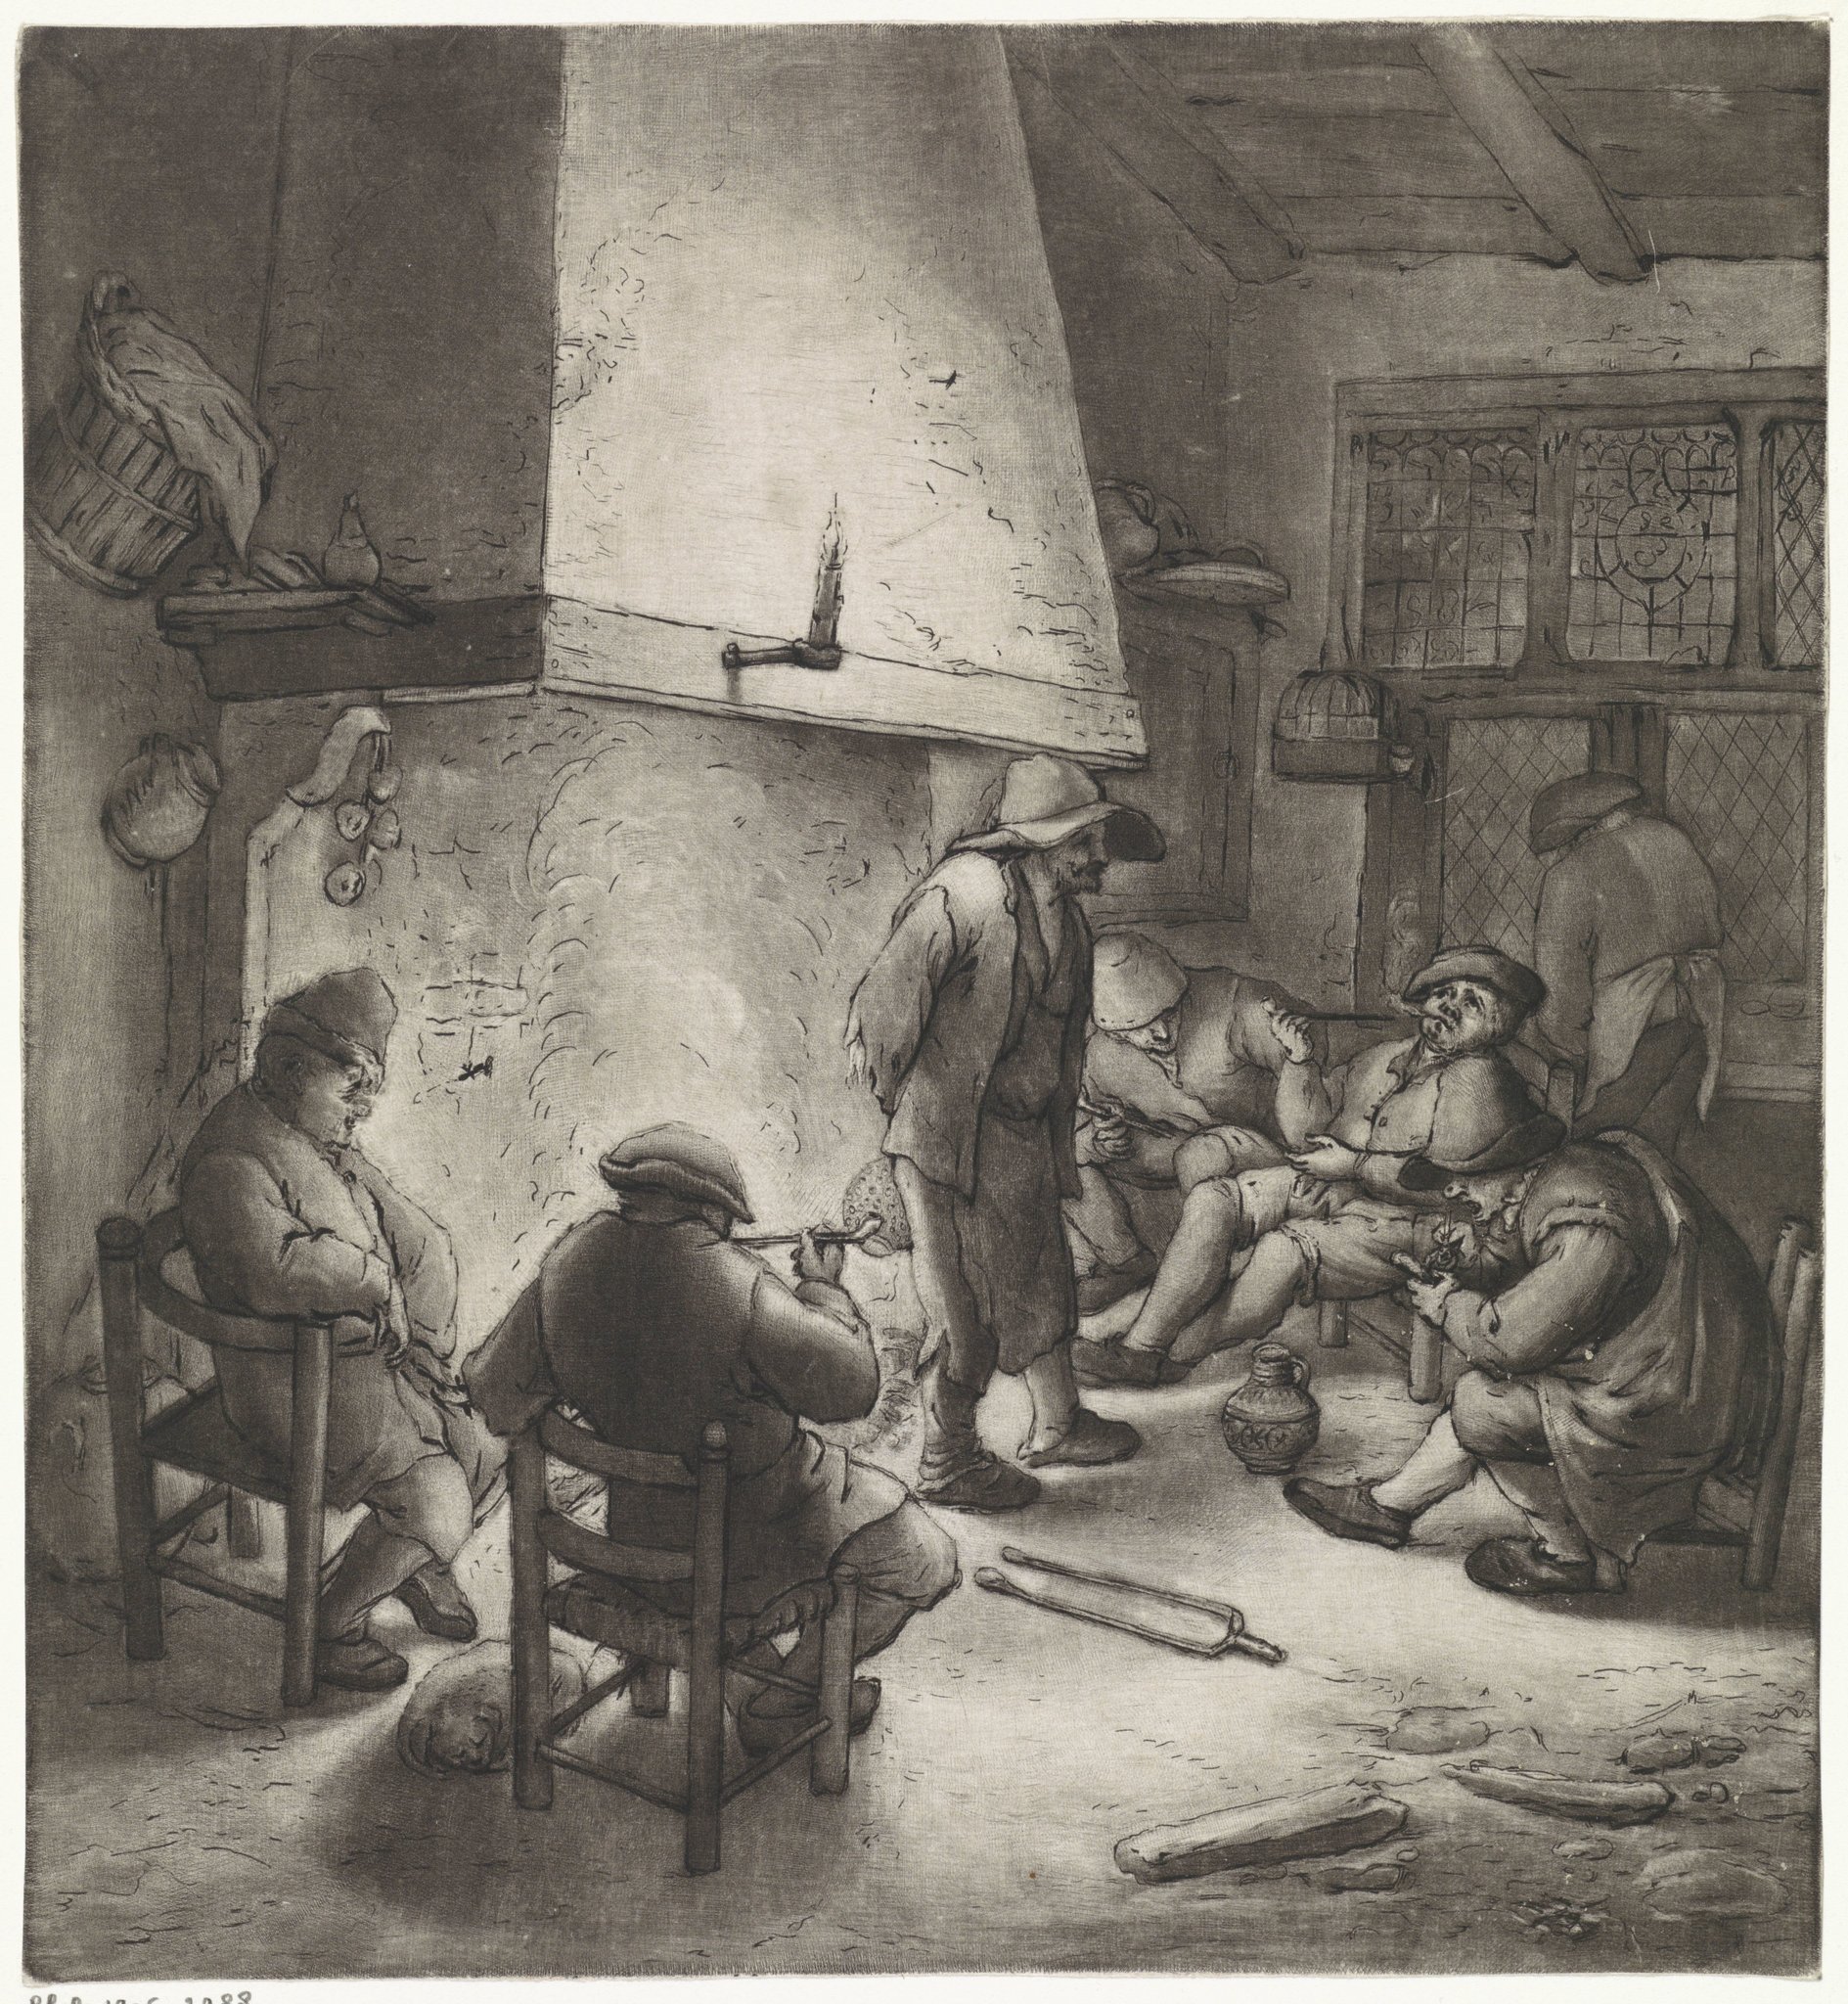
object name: print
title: Rokende boeren bij een schouw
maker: anthonie van den bos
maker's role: draughtsman, print maker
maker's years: 1763-1838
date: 1778-1838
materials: paper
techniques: etching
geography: amsterdam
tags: pipe ~ tobacco, open hearth, fire-place, farmers, hotel, hostelry, inn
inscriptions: collector's mark: Lugt 2228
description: Bij een haardvuur bevinden zich zeven boeren, waarvan er een met de rug naar de schouw staat. De boeren roken pijp en zitten onderuitgezakt in hun stoelen.